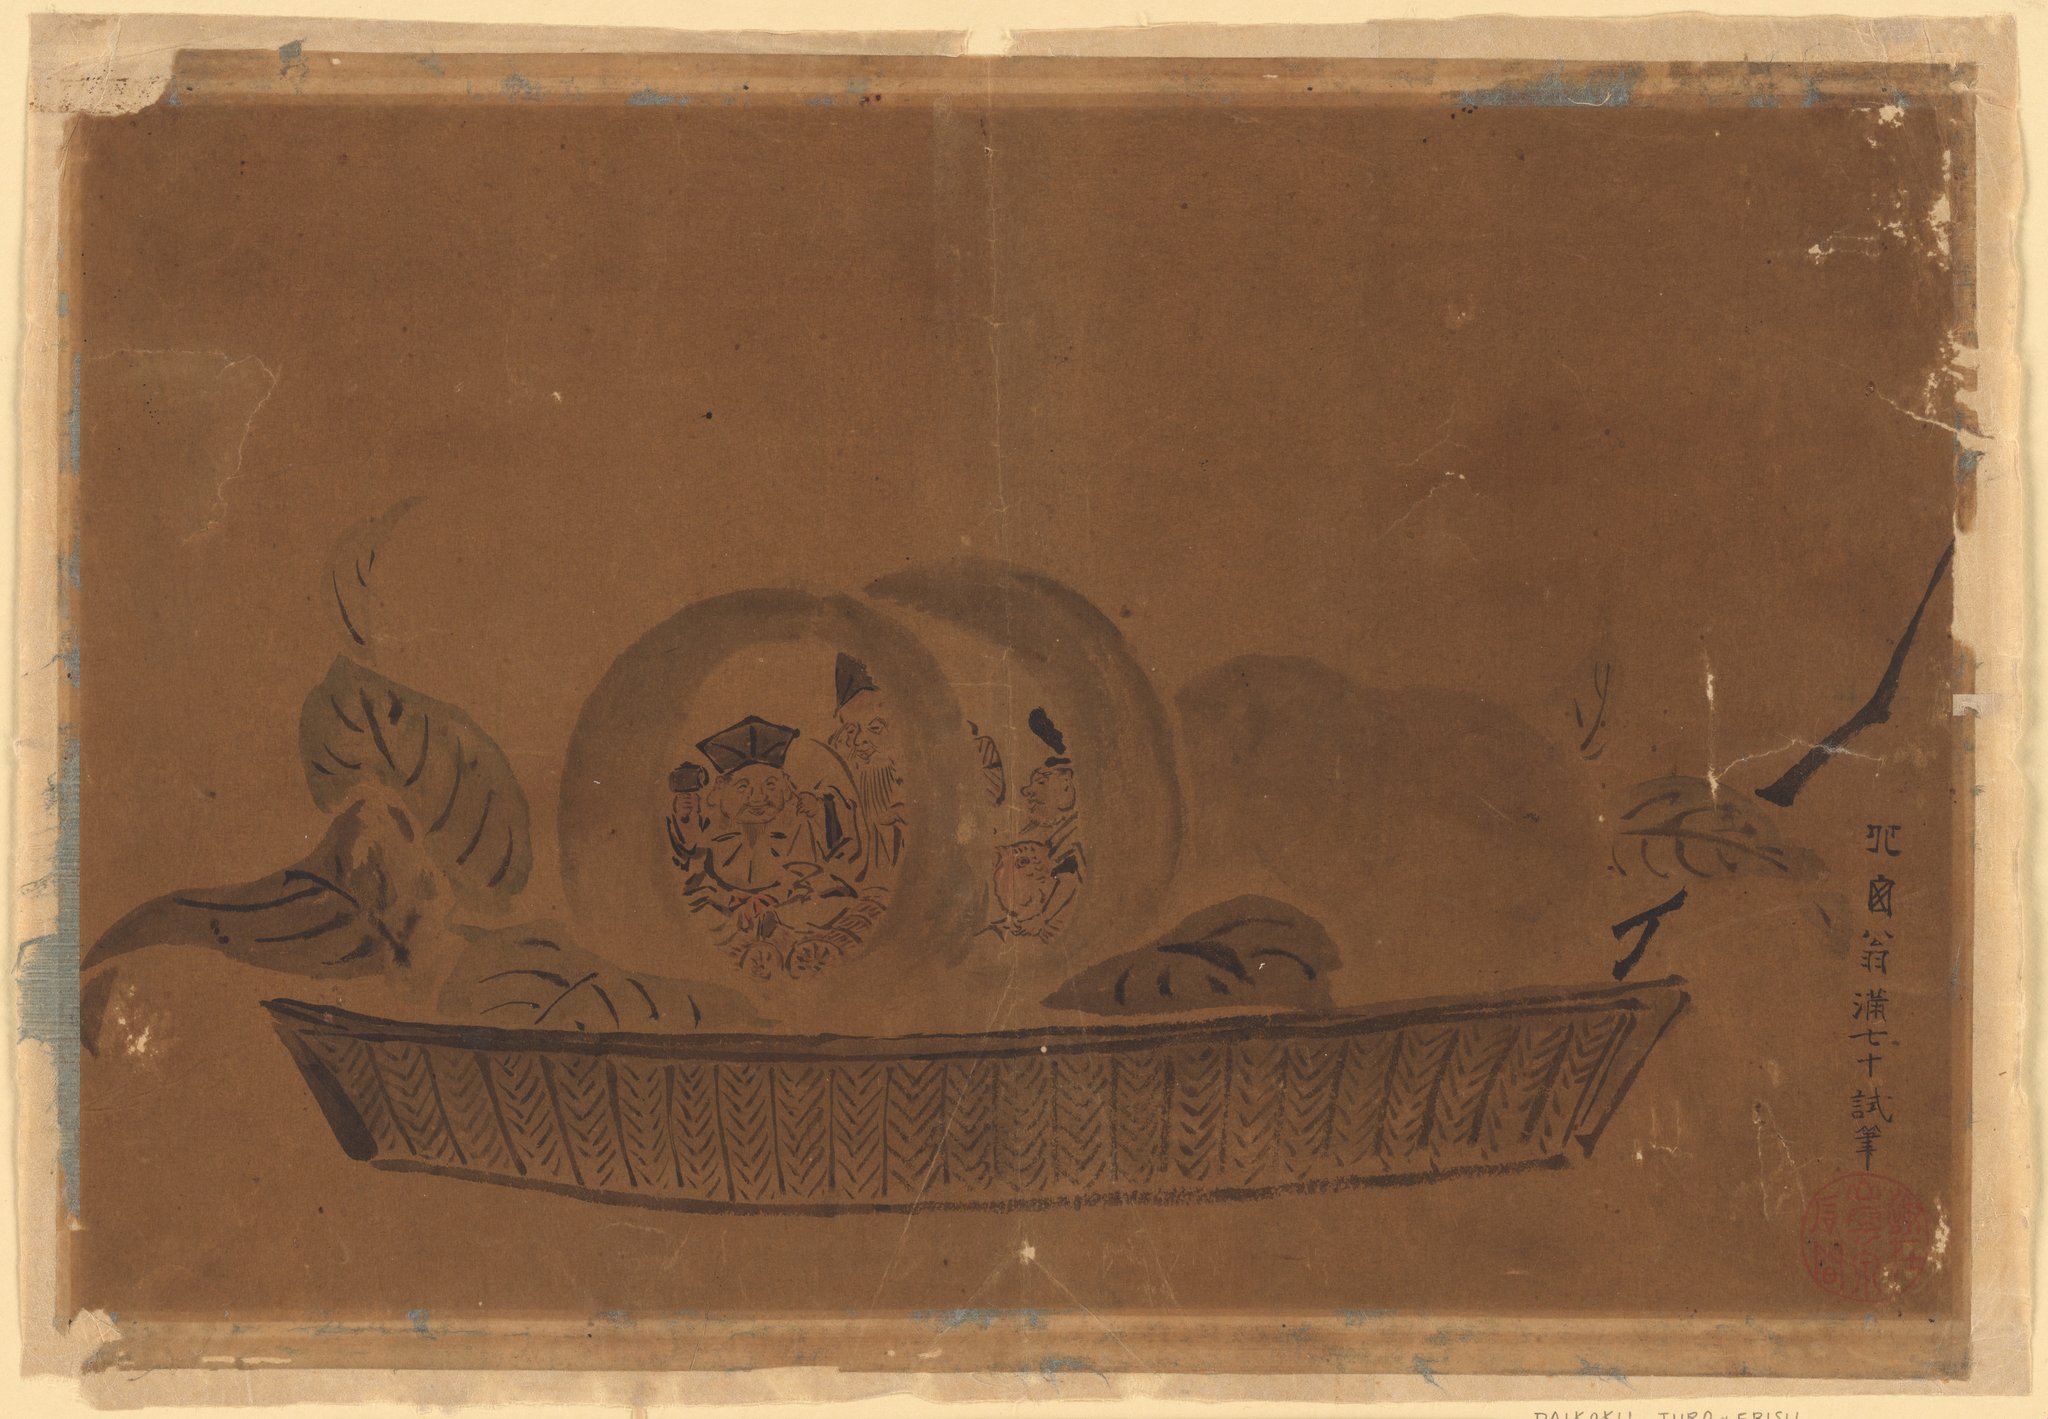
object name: drawing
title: Daikoku, Juro, and Ebisu (Gods of Luck)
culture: japanese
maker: katsushika hokusai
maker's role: artist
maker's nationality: japanese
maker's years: 1760-1849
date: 1701-1900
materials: ink, paper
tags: men,boats